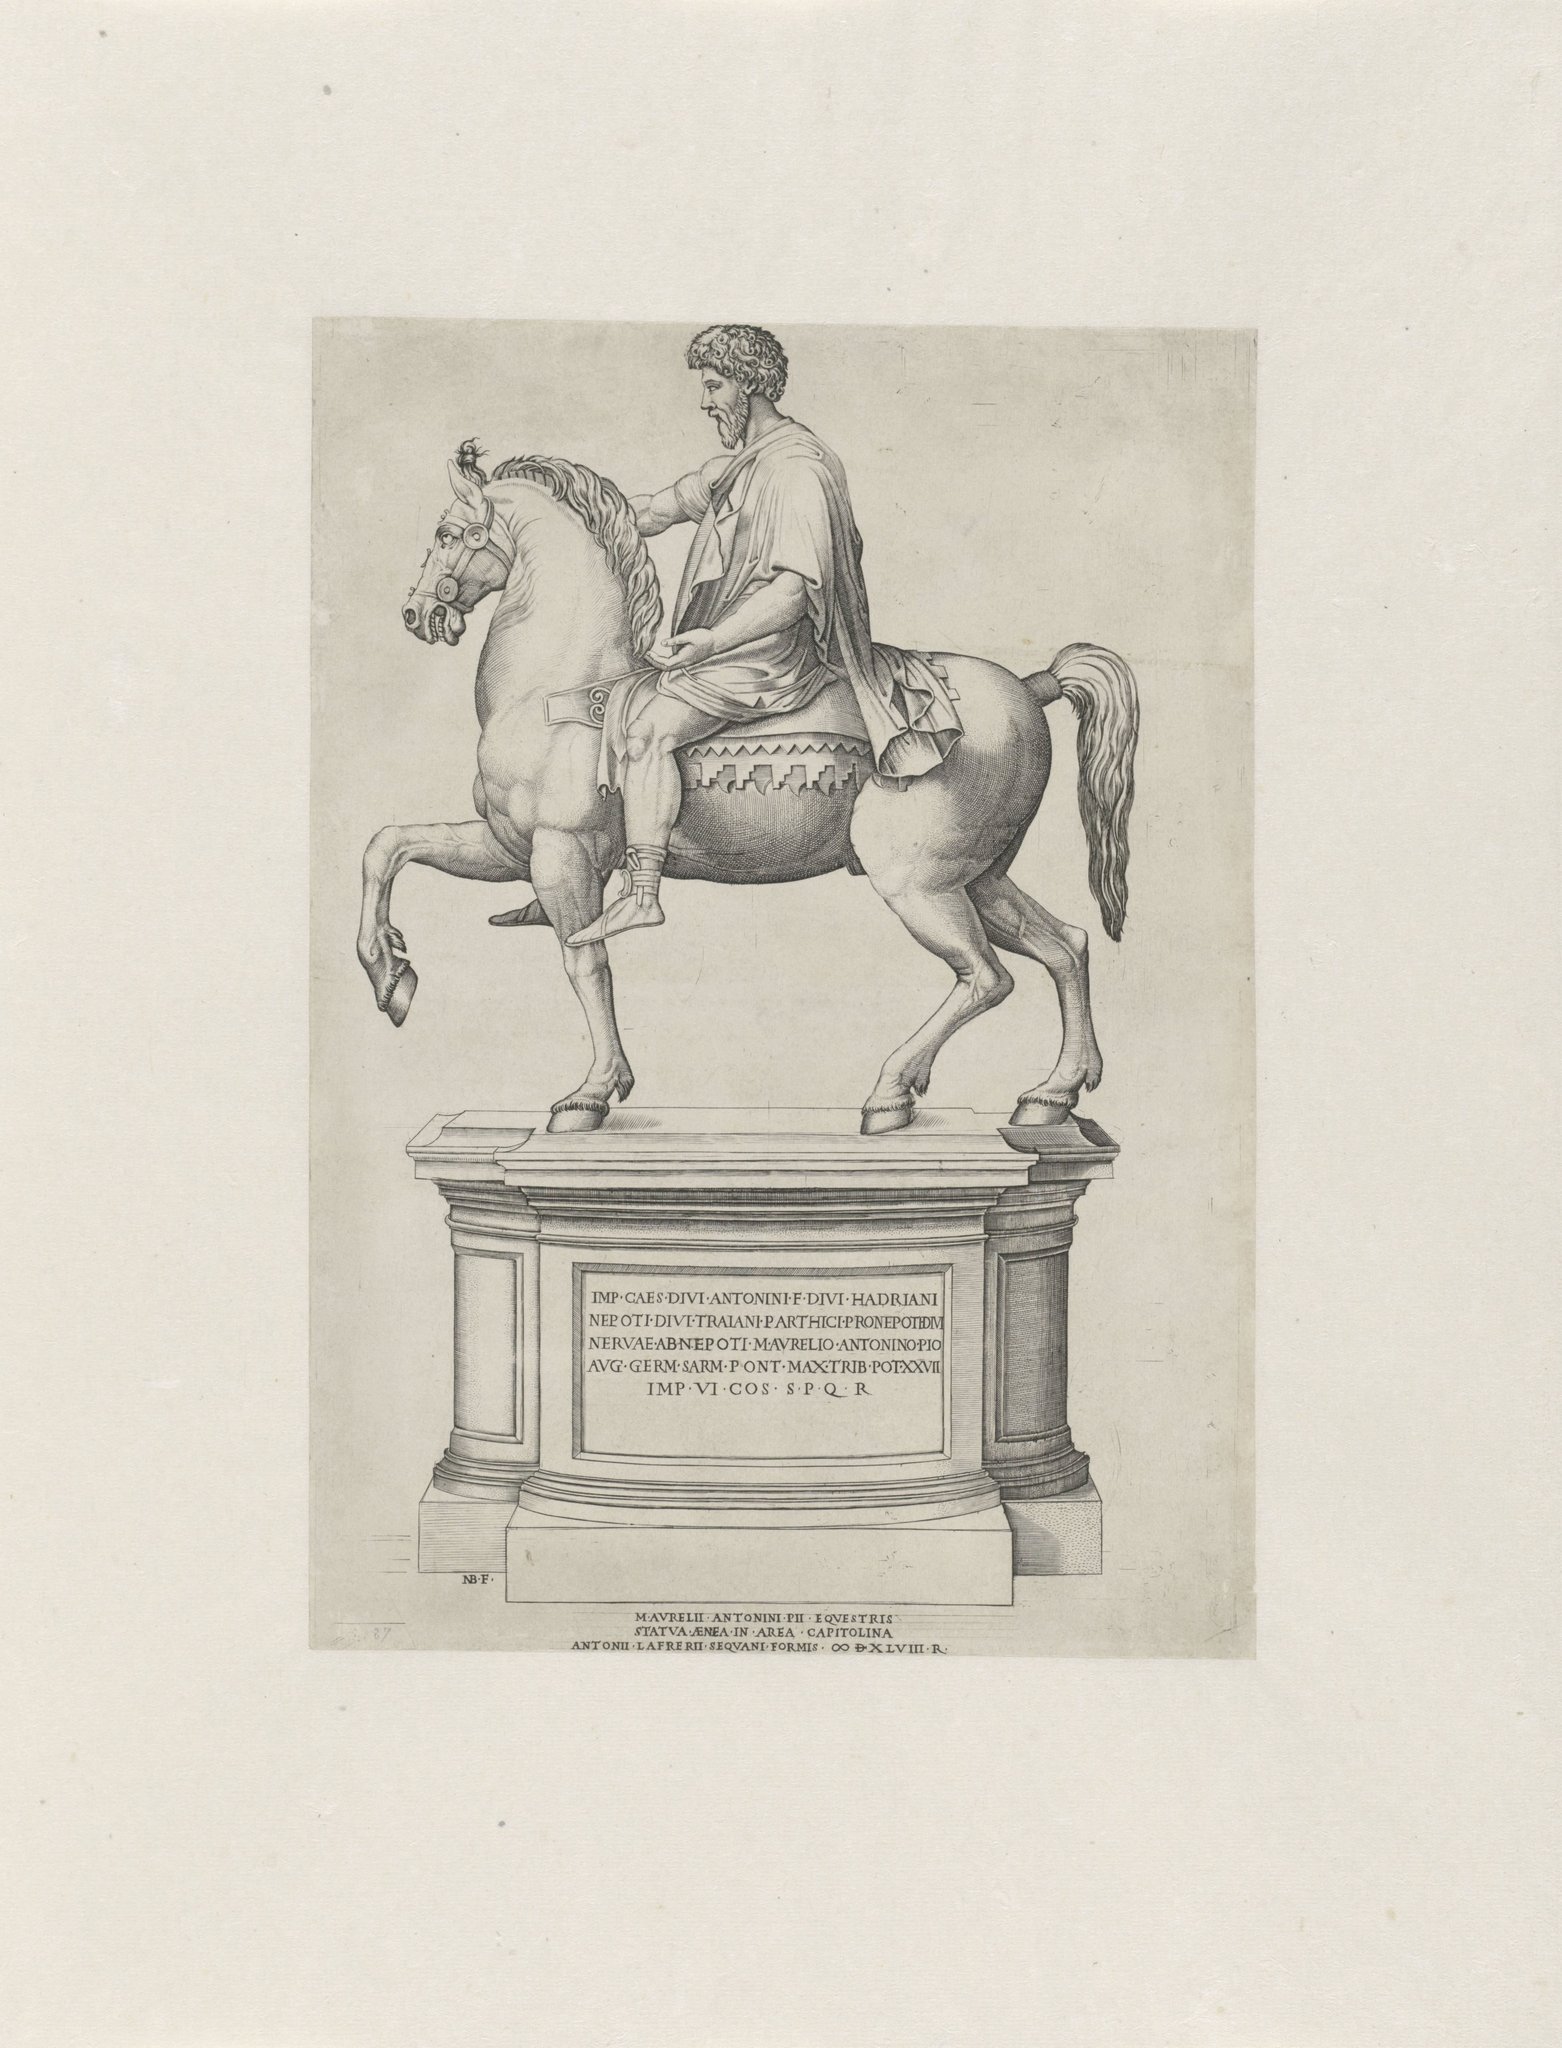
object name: print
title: Ruiterstandbeeld van Marcus Aurelius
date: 1548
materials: paper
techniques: engraving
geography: rome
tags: rome, equestrian statue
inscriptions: collector's mark: Lugt 2228, collector's mark: Lugt 2760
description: Het ruiterstandbeeld van Marcus Aurelius op Piazza del Campidoglio in Rome.